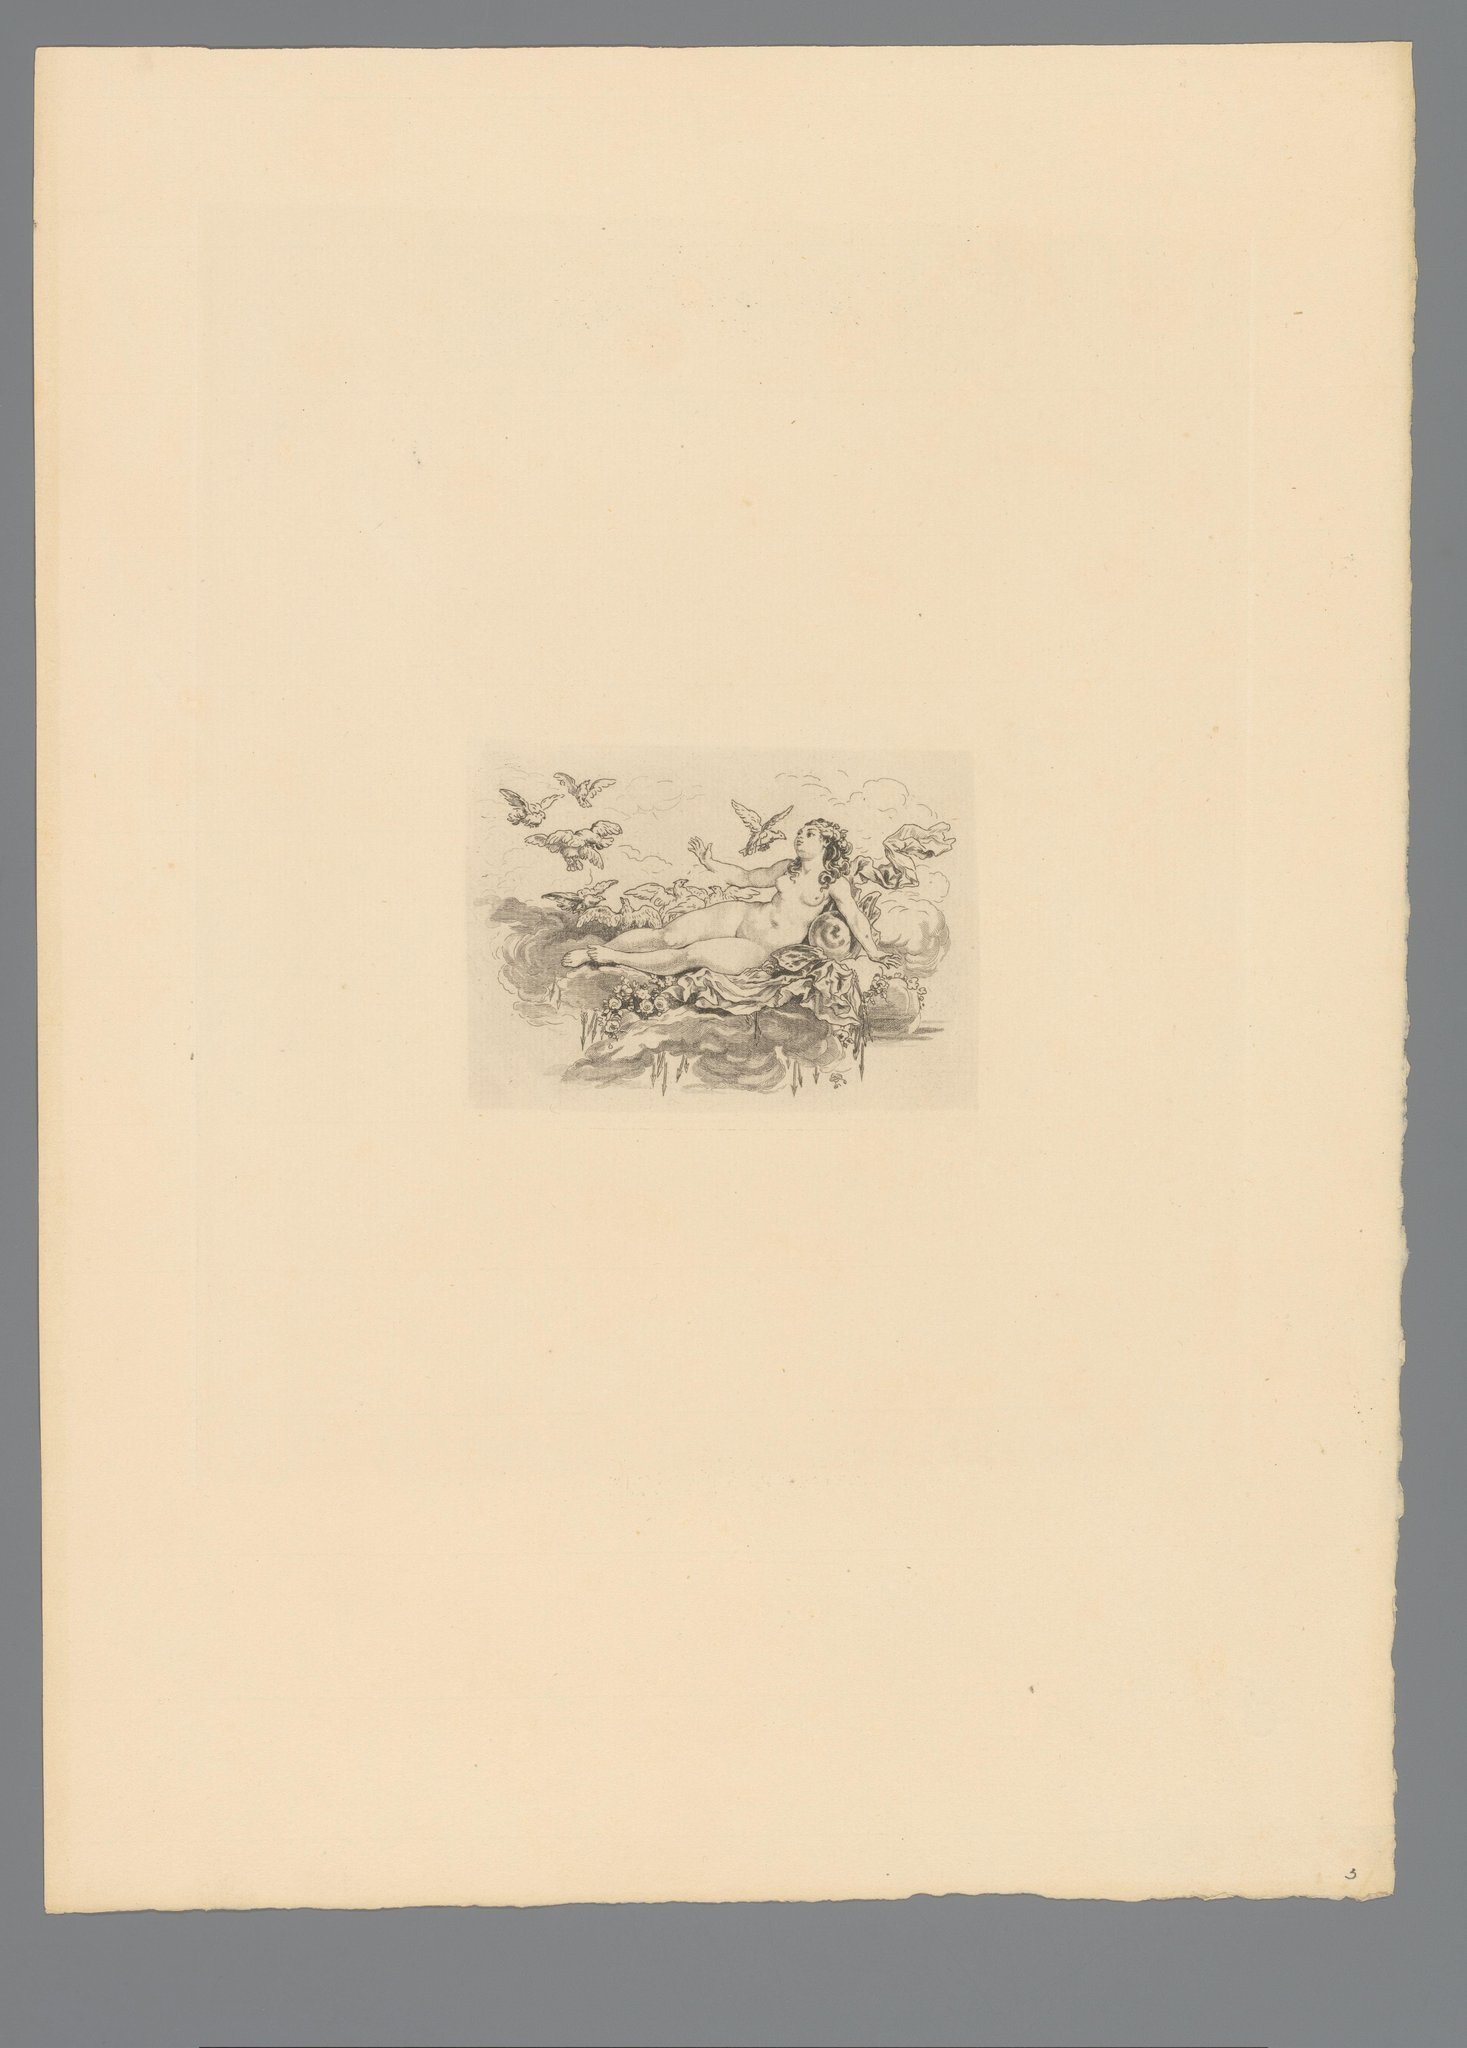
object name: vignette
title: Figuren uit de verhalen van La Fontaine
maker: Anonymous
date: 1880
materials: paper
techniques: photoaquatint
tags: single muses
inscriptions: collector's mark: Lugt 2228, collector's mark:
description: Martial Potémont maakte etsen naar de tekeningen van Fragonard, die zich bevonden in een manuscript in de collectie van de verzamelaar Eugène Paillet. Rouquette bood hem aan de tekeningen zo exact mogelijk in prent te laten brengen door Martial Potémont: dit resulteerde in een serie van 57 etsen. Vervolgens werden deze gereproduceerd door middel van heliogravure. Deze omslag betreft een editie voor de letter, "Eau forte pure", de 1e staat van 3 waar men uit kon kiezen bij deze serie.